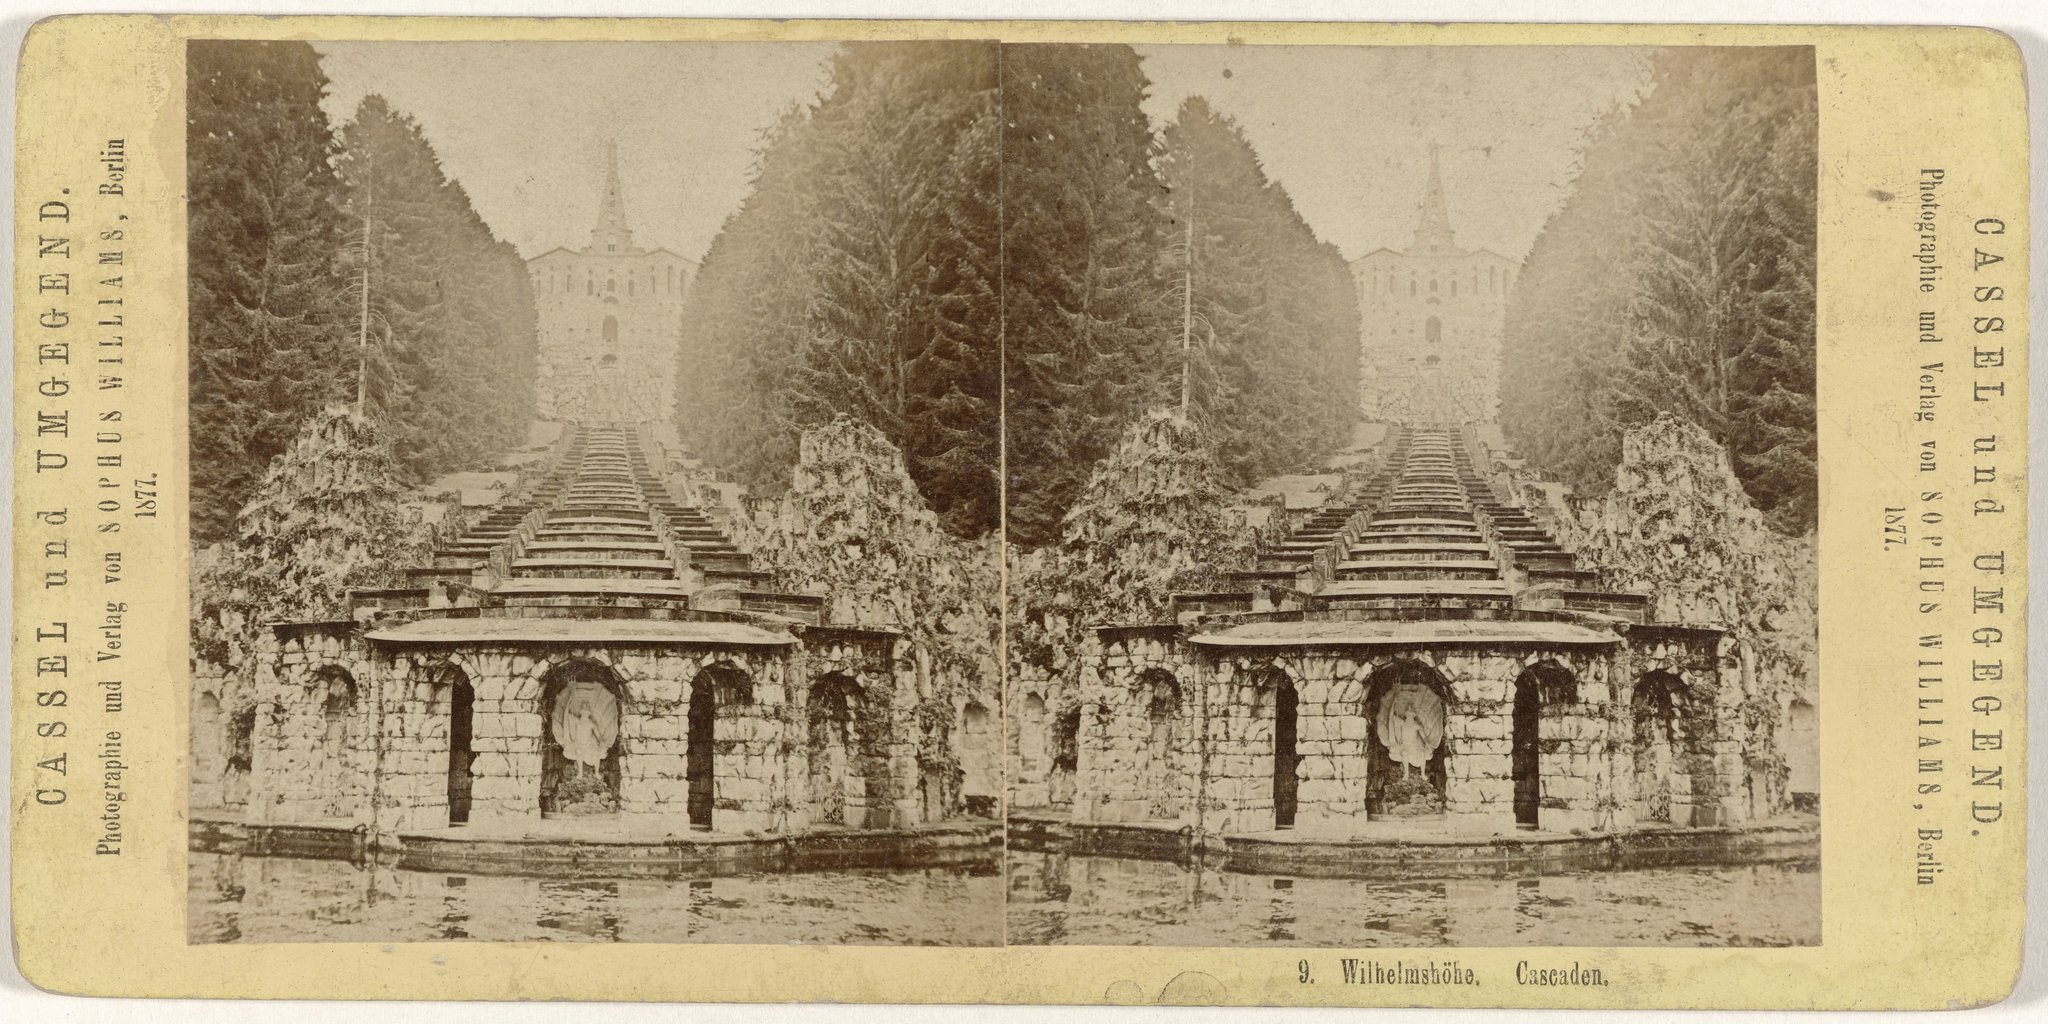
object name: stereograph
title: Wilhelmshöhe. Cascaden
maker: sophus williams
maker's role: publisher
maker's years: 1835-1900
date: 1877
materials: cardboard, paper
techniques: albumen print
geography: kassel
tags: landscape with monument, garden cascade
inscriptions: number: ‘9.’